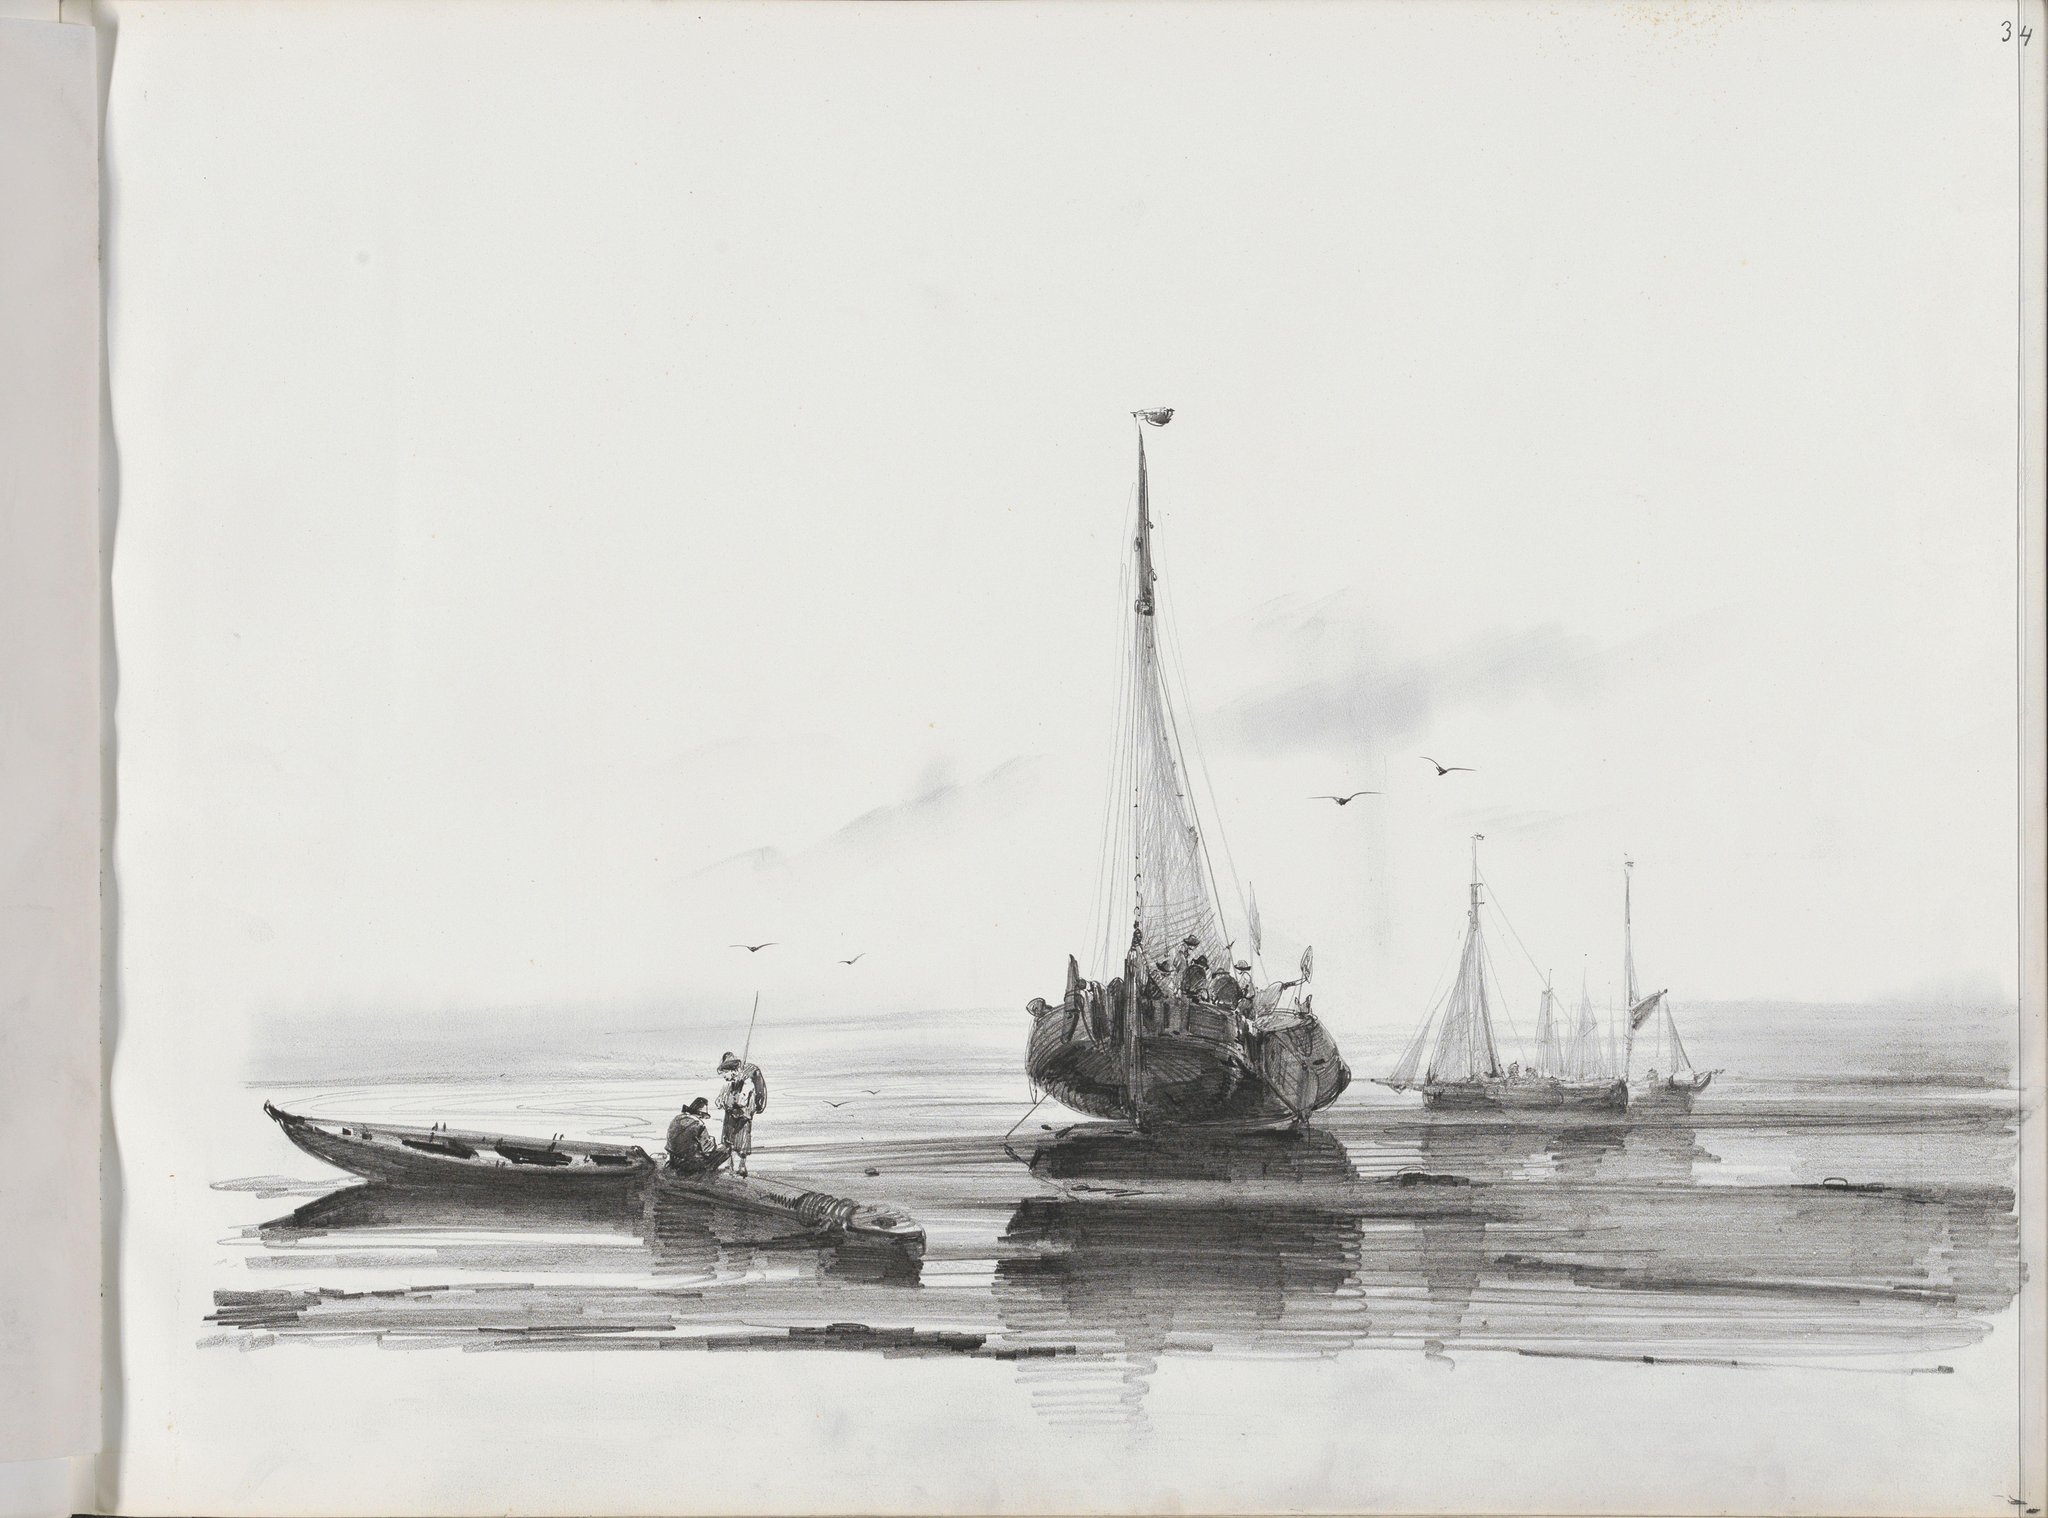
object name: sketchbook leaf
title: Bomschuit voor een kust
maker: albertus van beest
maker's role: draughtsman, print maker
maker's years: 1820-1860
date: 1830-1860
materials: paper, pencil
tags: sailing-ship, sailing-boat, landscapes with waters, waterscapes, seascapes (in the temperate zone), rowing-boat, canoe, etc.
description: Op de achtergrond zeilboten. Op de voorgrond twee mannen bij een roeiboot. Blad 34 recto uit een schetsboek met 46 bladen.